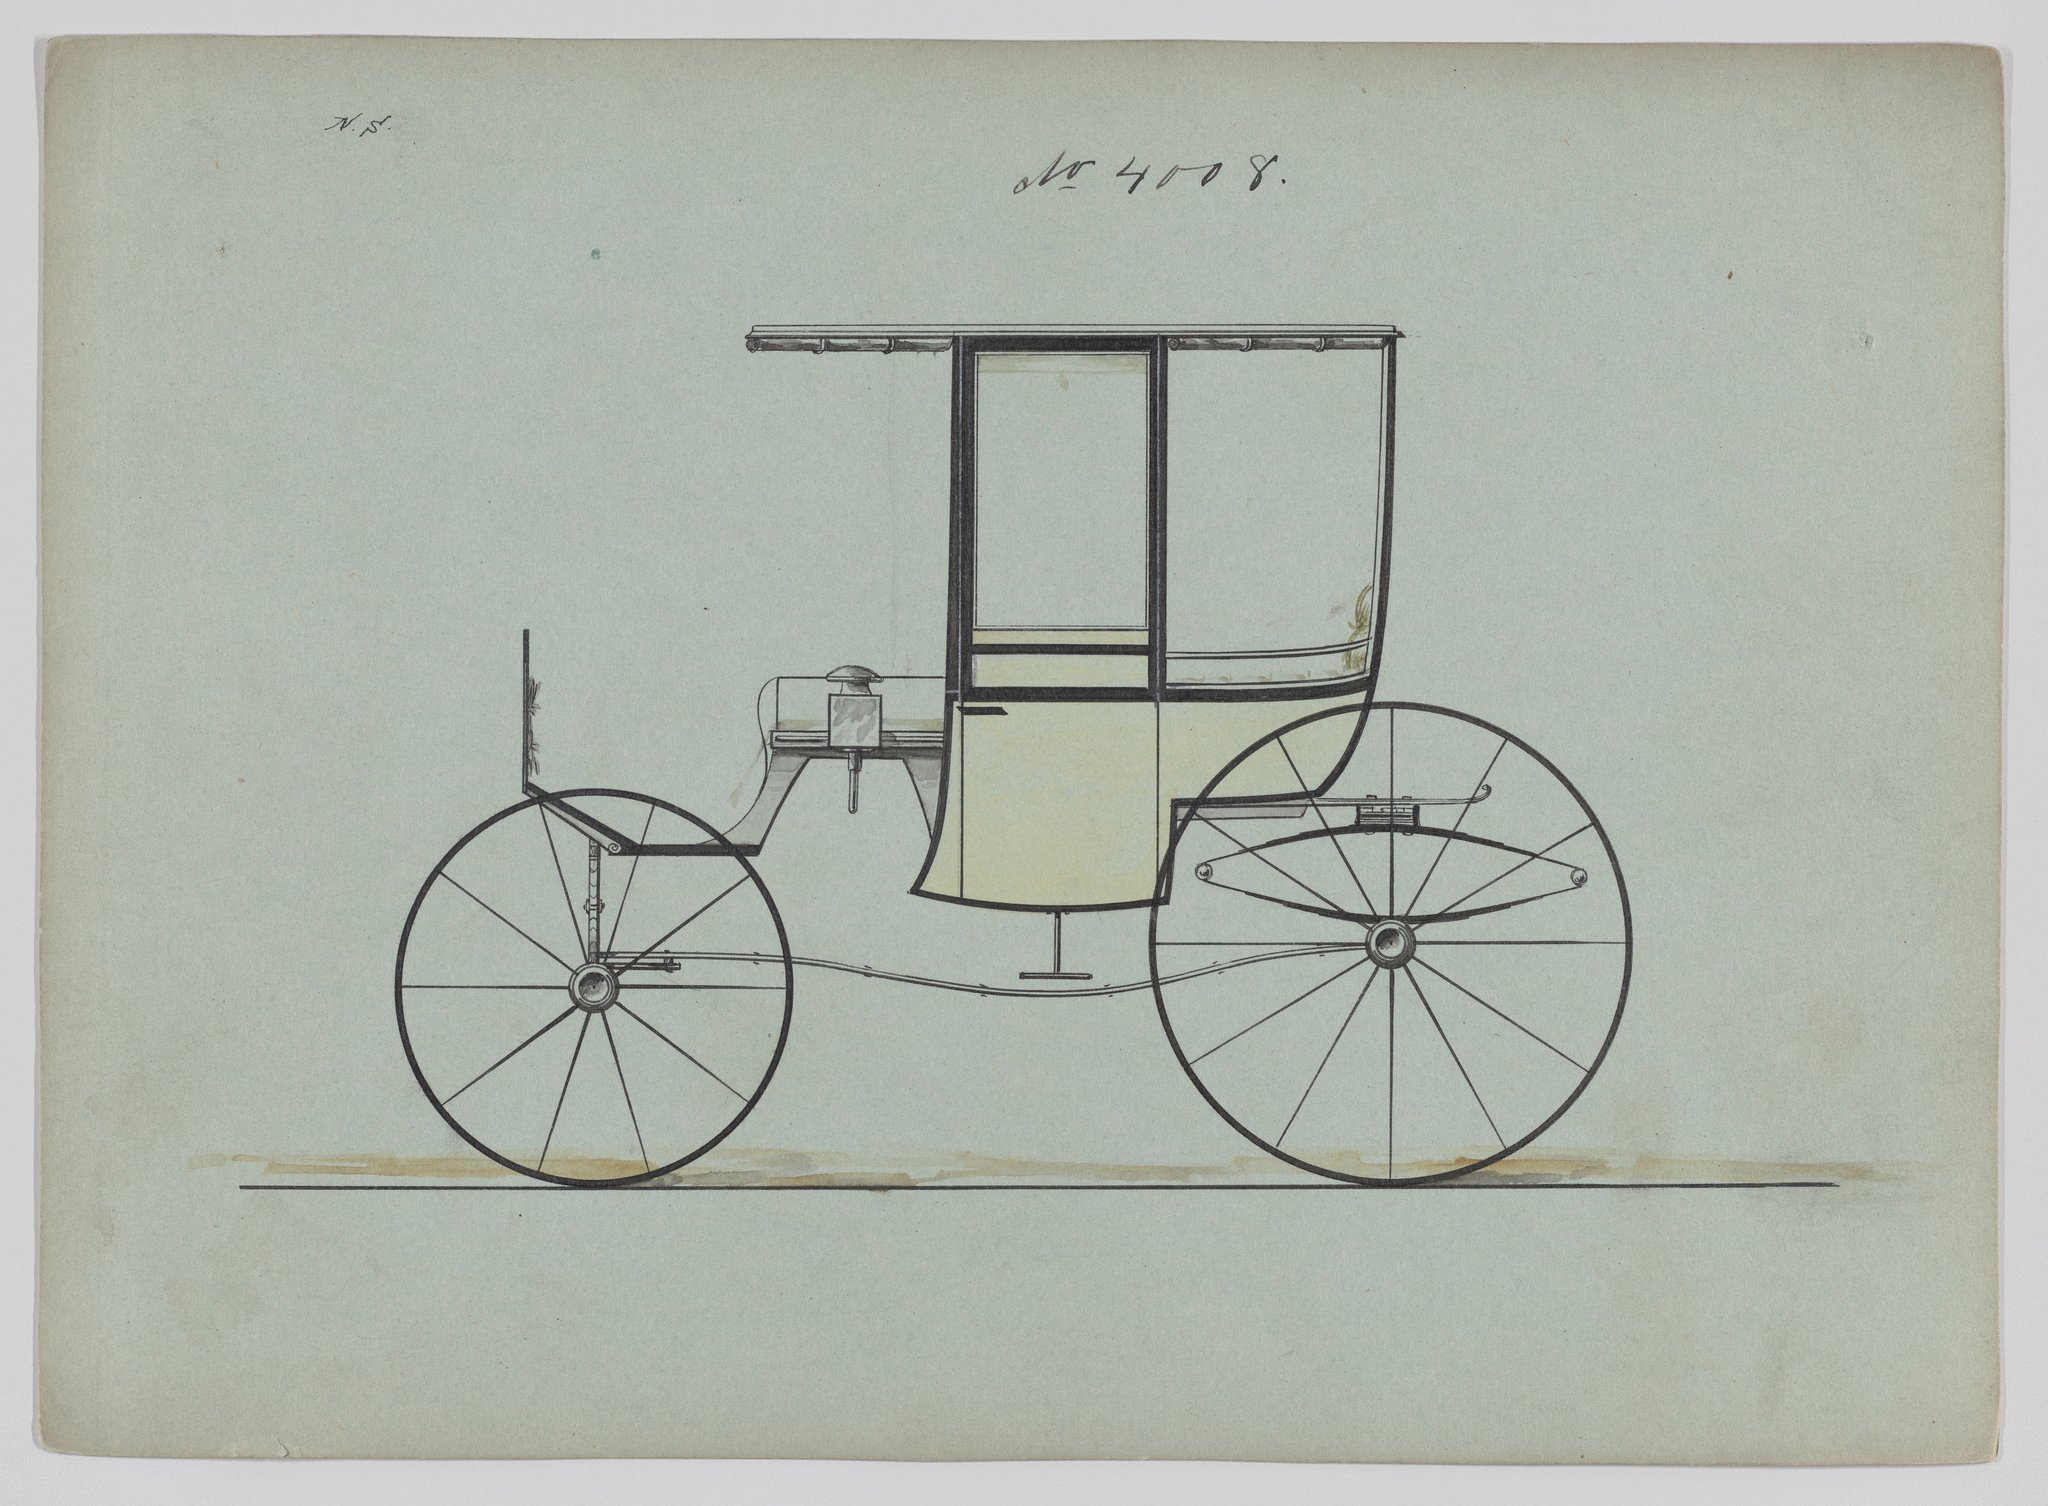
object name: drawing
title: Design for 4 seat Rockaway, no. 4008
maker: brewster & co.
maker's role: manufacturer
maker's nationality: american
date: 1888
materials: gouache, gum arabic, ink, watercolor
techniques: pen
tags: carriages